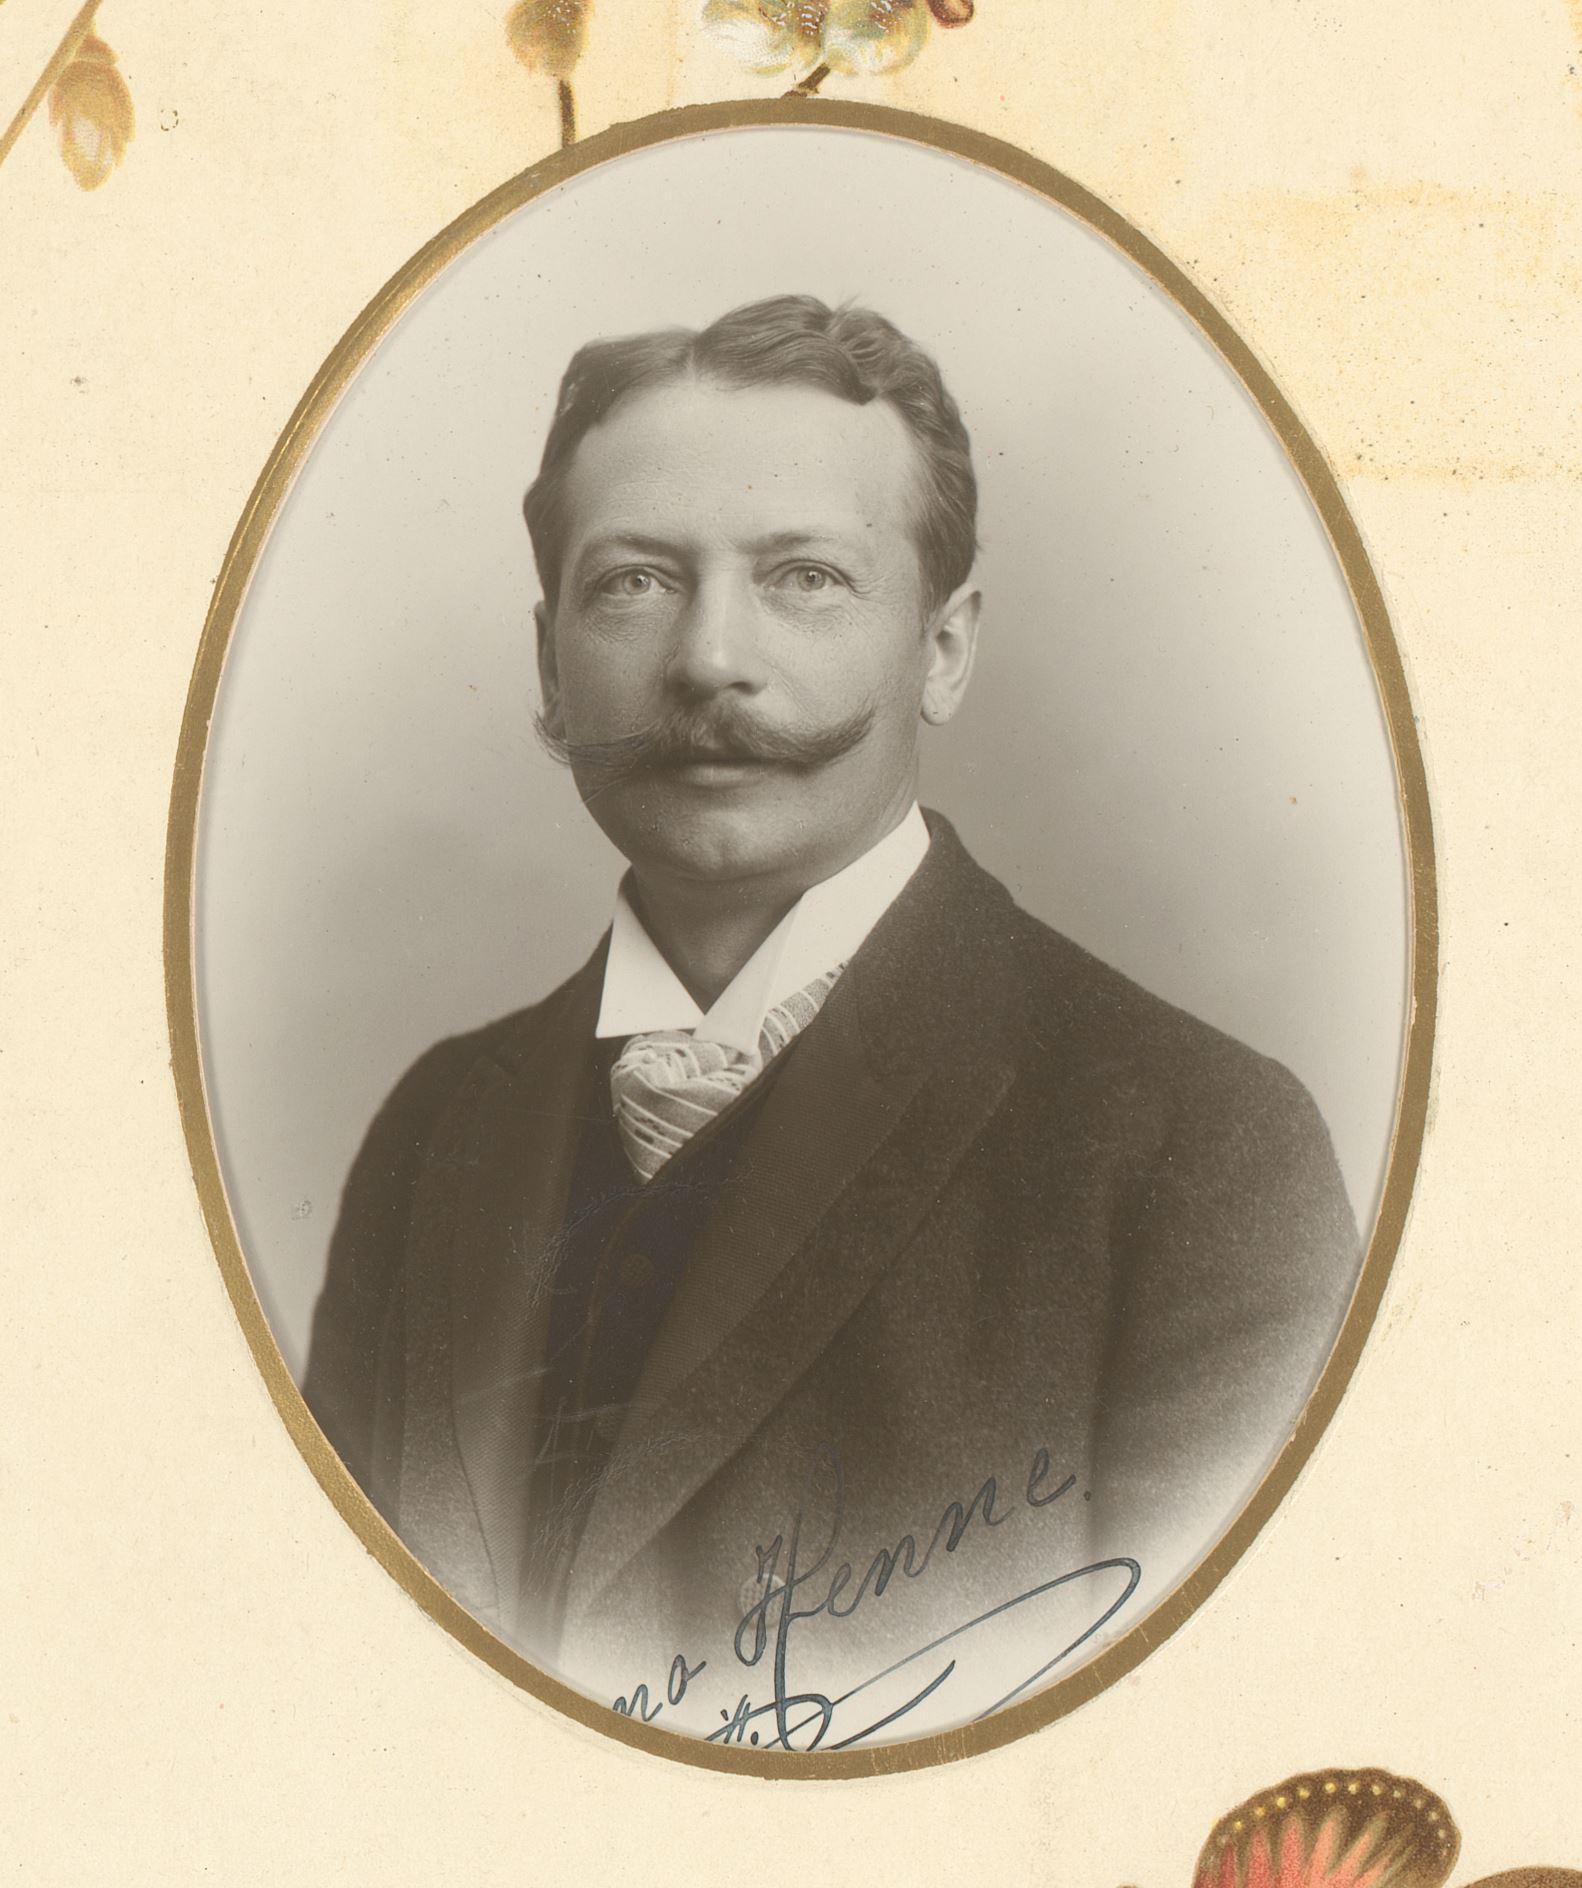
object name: photograph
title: Portret van Bruno Henne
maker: eduard uhlenhuth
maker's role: fotograaf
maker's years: 1853-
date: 1909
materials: cardboard, photographic support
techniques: matte daylight collodion silver print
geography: coburg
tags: historical persons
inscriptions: annotation: ‘Zur Familie Ehrhardt/ zur freundlichen Erinnerung/ [...]/ [...] Agnes/ zum/ [...]mal/ Coburg November/ 1909.’, annotation: ‘Bruno Henne/ Meine [...] a.D.’, inscription: ‘(...)/ Professor E. Uhlenhuth/ (...)/ Coburg/ am Albertplatz./ Schweinfurt, gegenüber dem Schrotthurm./ Von diesem Bilde kann stets nachbestellt und jede/ Art Vergrösserung angefertigt werden.’